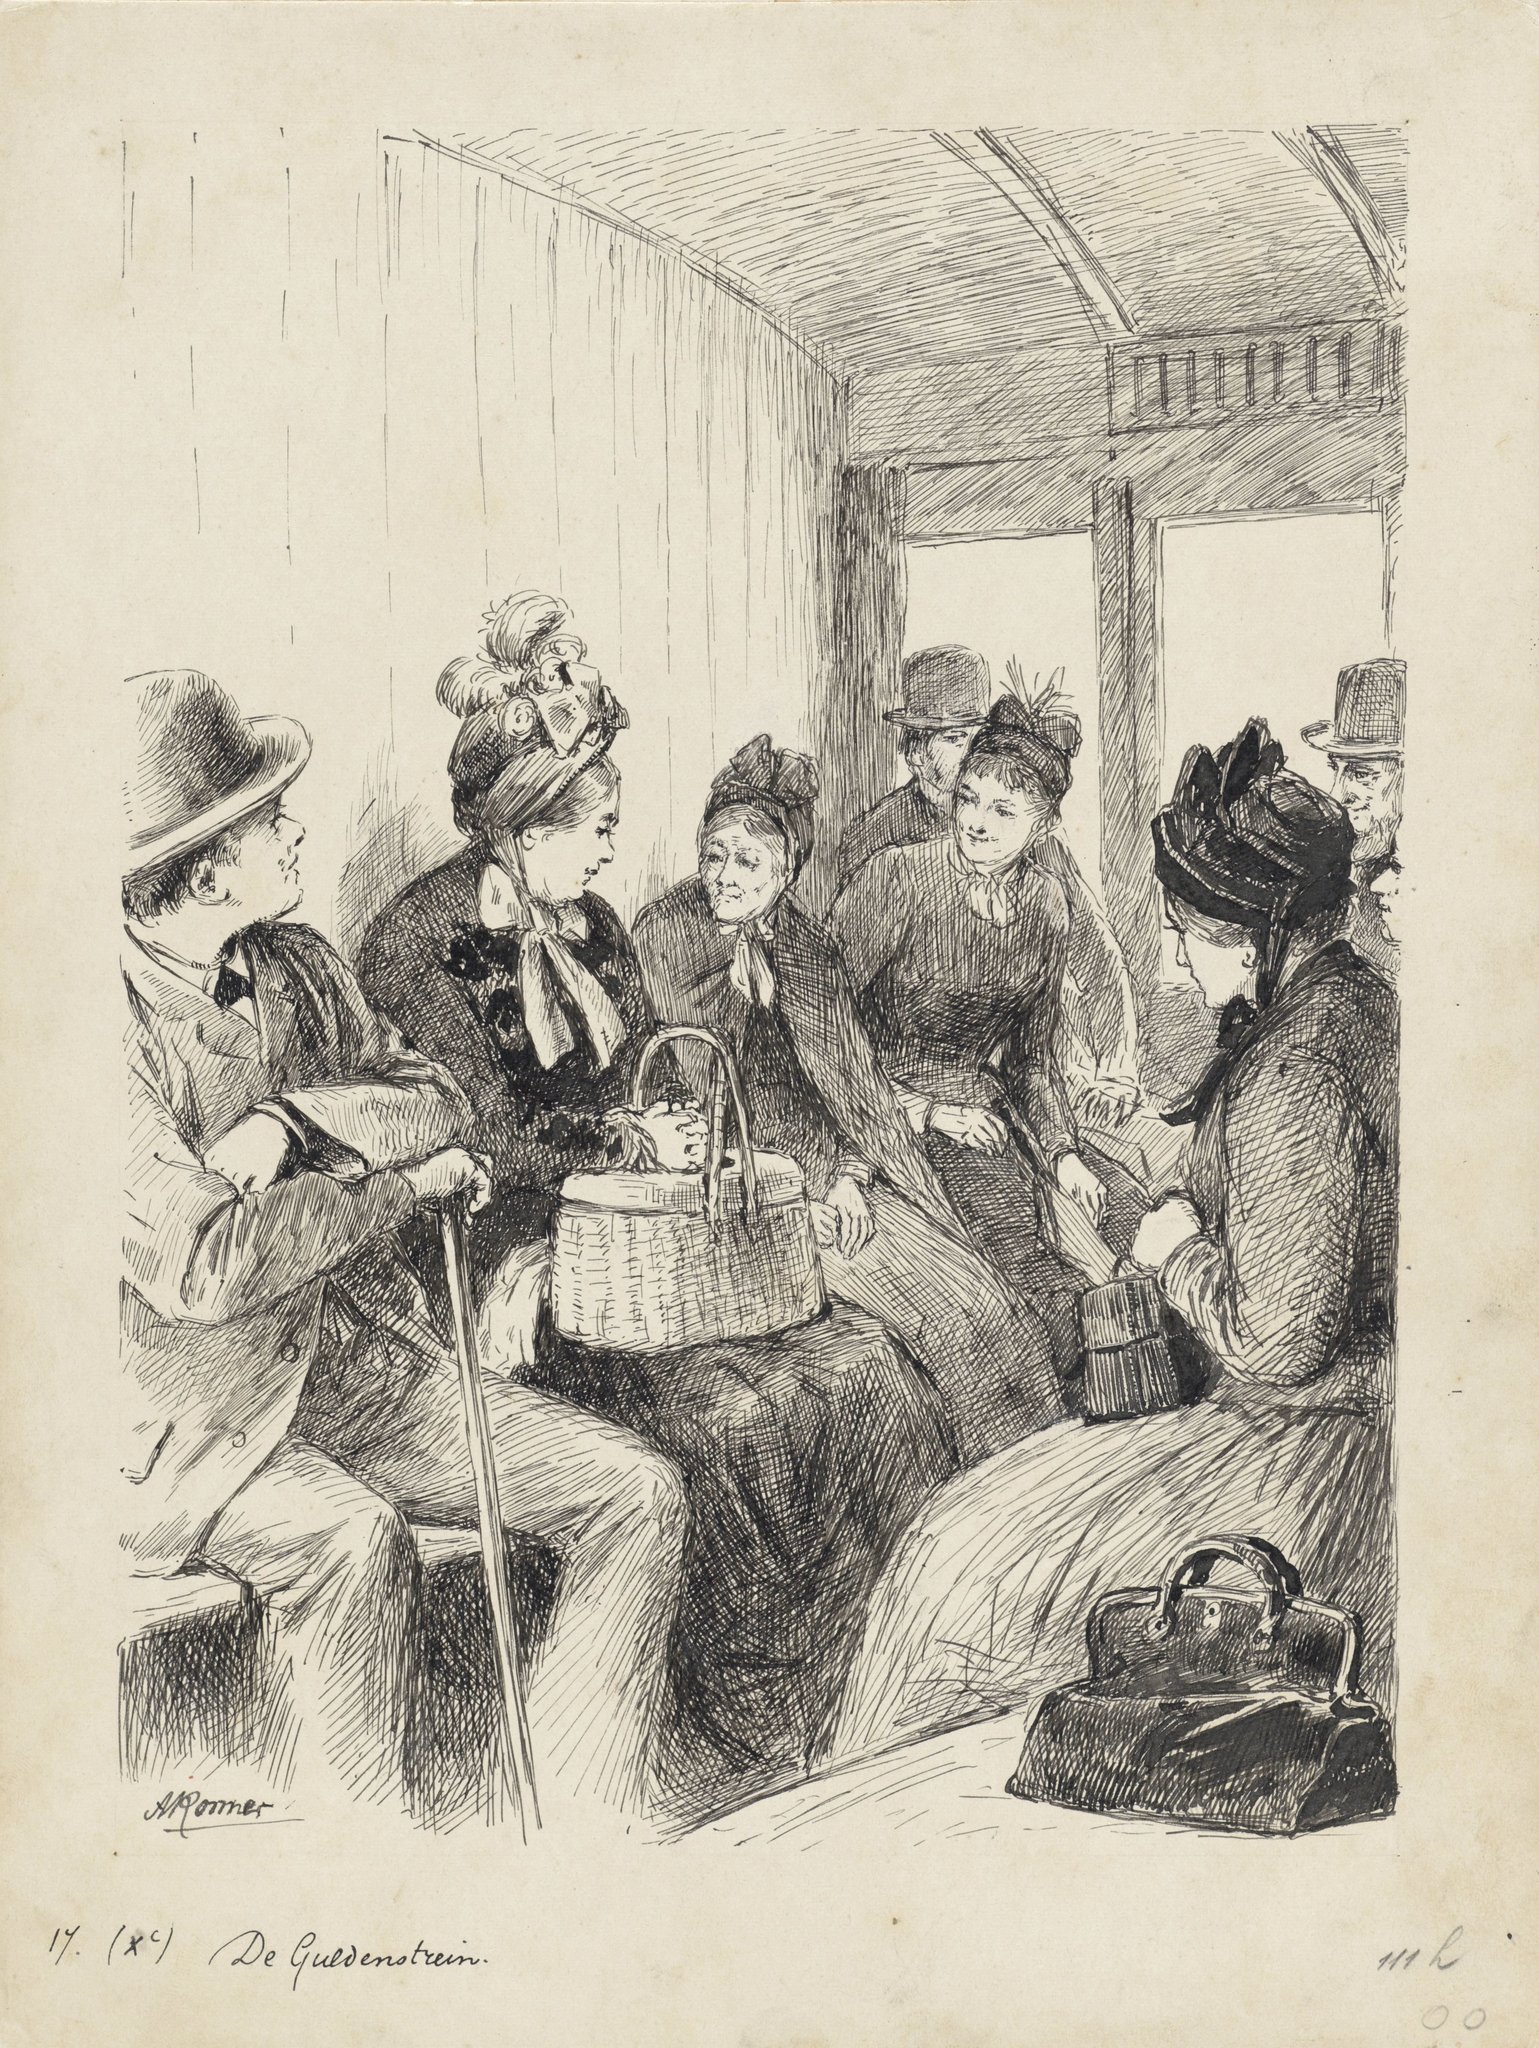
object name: design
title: De Guldenstrein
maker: alfred ronner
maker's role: draughtsman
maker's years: 1852-1901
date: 1893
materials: ink, paper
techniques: pen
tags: railway-traffic, (reiger, a.f.j., vluchtige schetsen uit het volksleven) specific works of literature (with author, title)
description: Illustratie voor 'Vluchtige Schetsen uit het Volksleven' door A.F.J. Reiger. Ontwerp voor een prent.